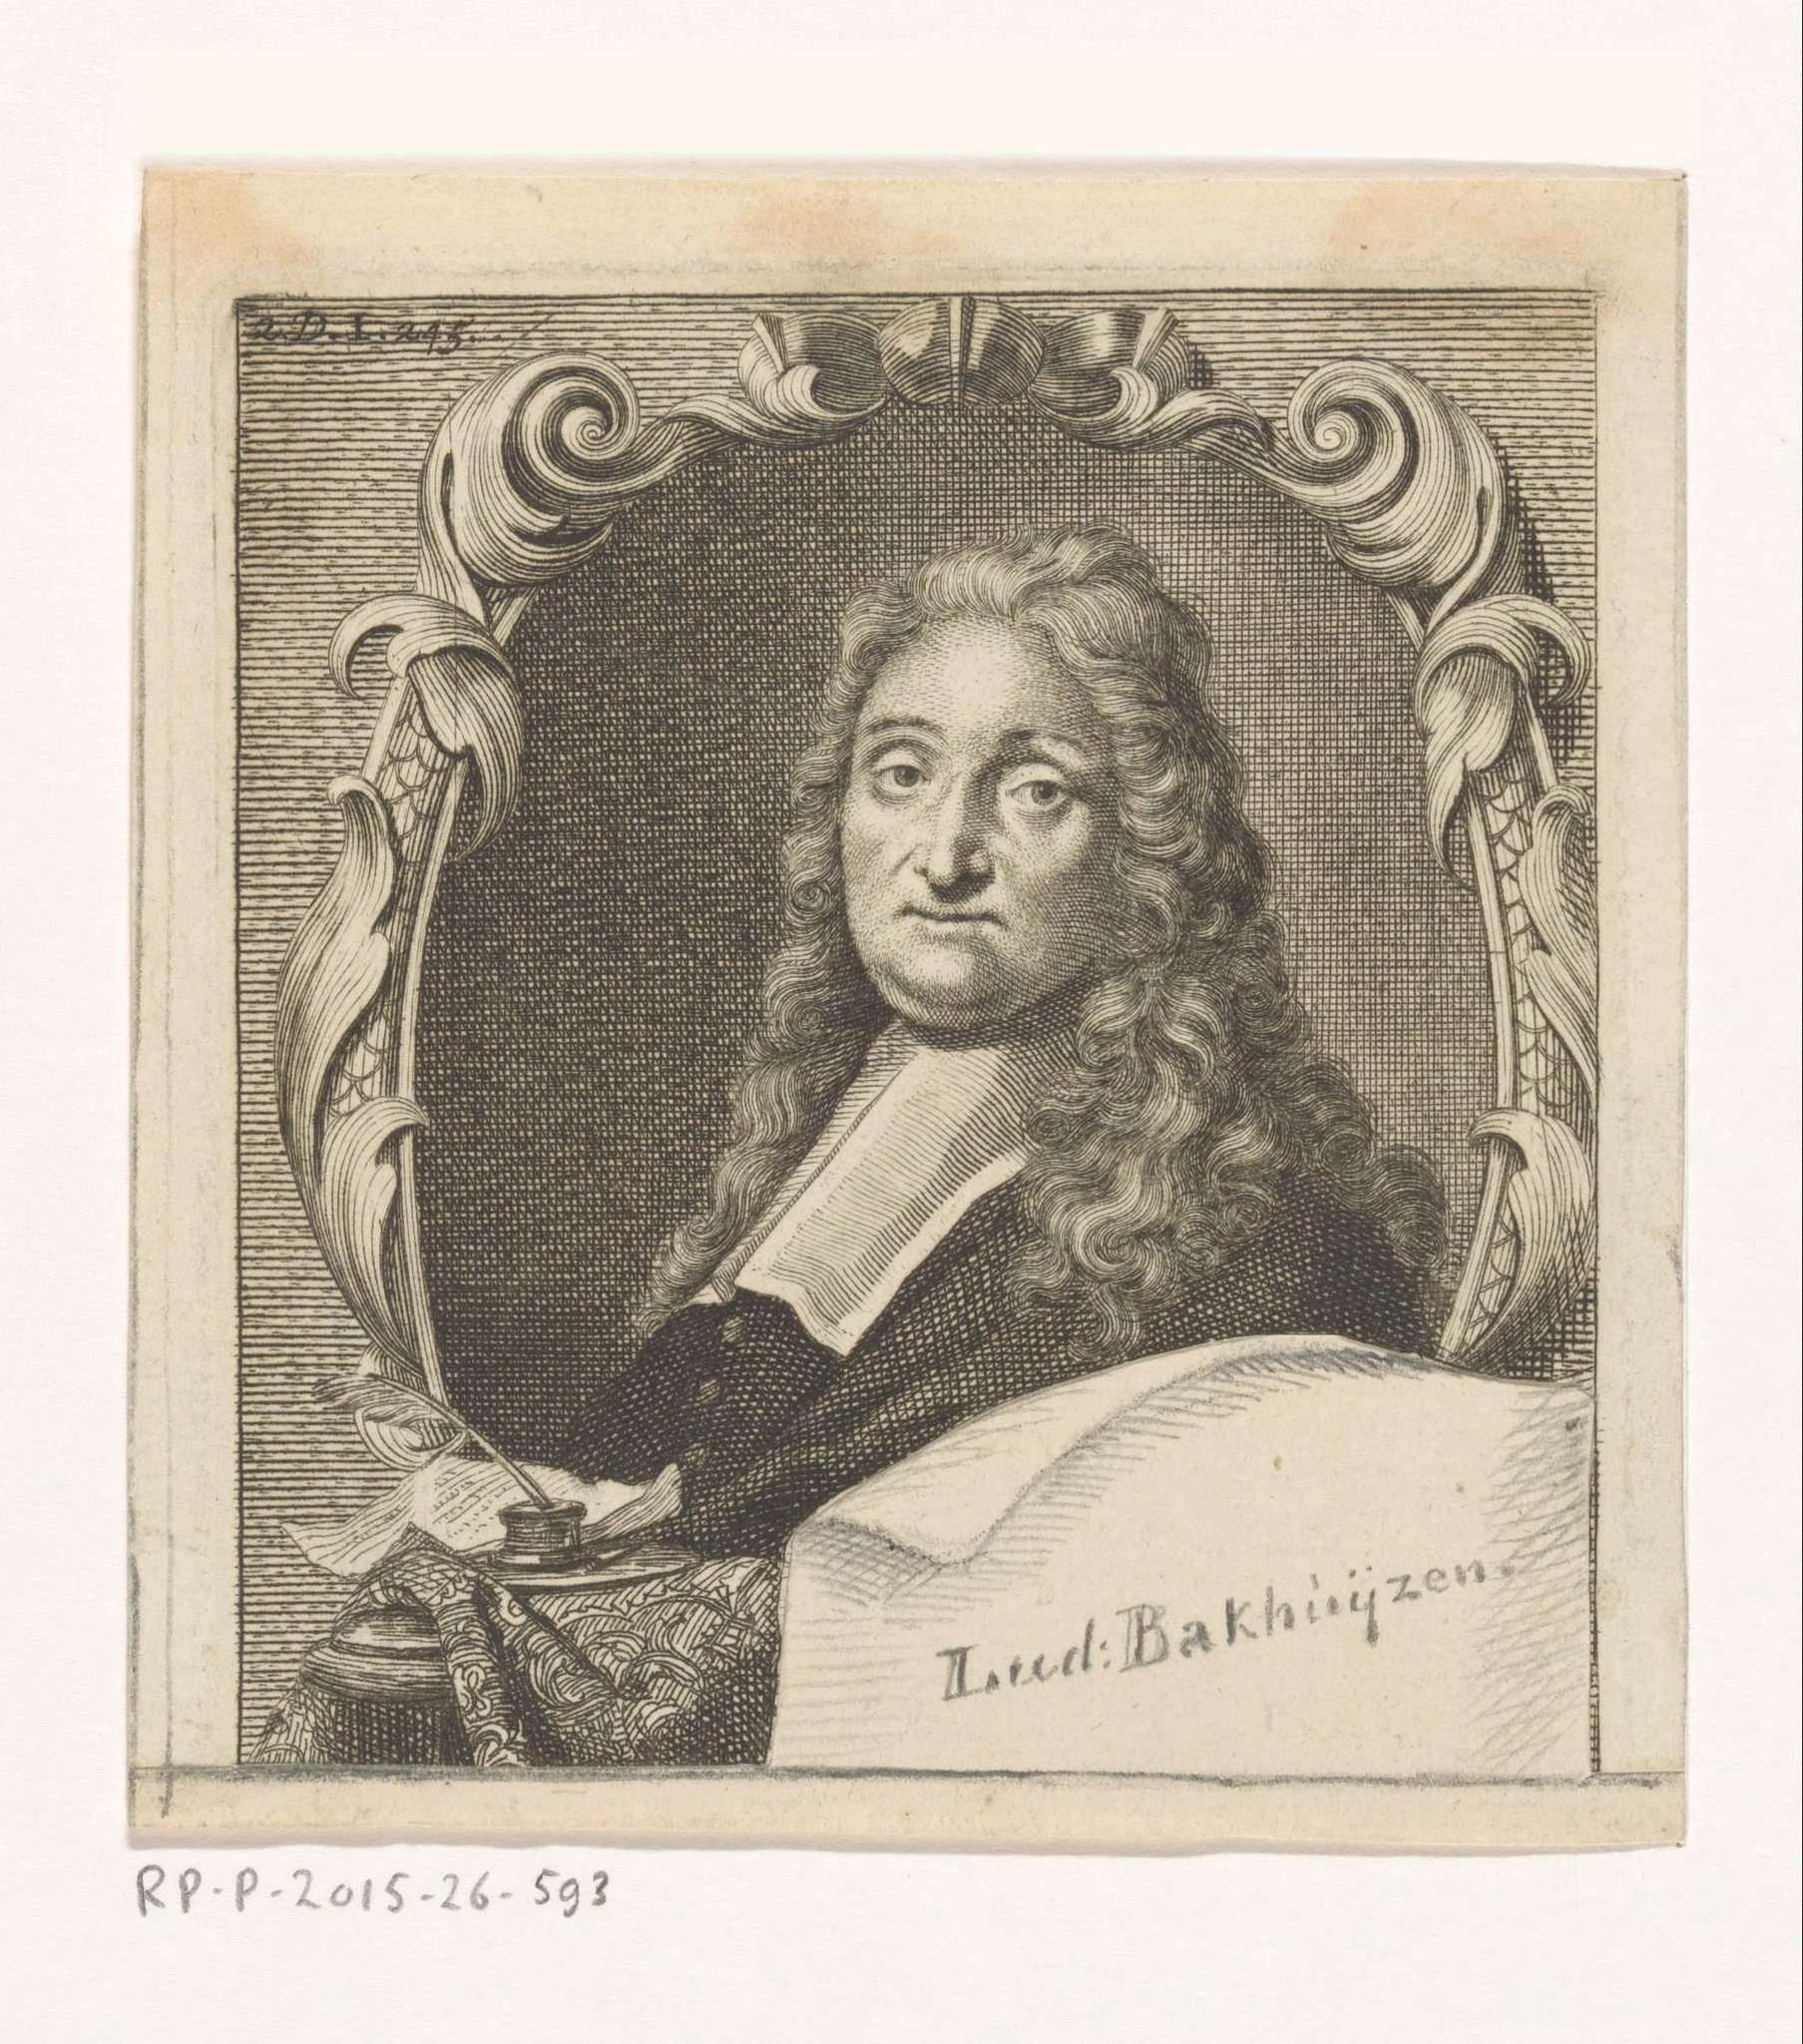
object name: book illustration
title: Portret van Ludolf Bakhuysen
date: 1753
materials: paper, pencil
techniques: engraving, etching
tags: draughtsman, ludolf bakhuysen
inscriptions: collector's mark: Lugt 4779, collector's mark: Lugt 2228, collector's mark: Lugt 4780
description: Prent afkomstig uit: Houbraken, Arnold. De groote schouburgh der Nederlantsche konstschilders en schilderessen. 3 Dln. Den Haag: Swart, Boucquet en Gaillard, 2e druk, 1753, dl. 1, voor p. 245. Een ander portret dat zich op dezelfde prent bevond is weggesneden en vervangen door een stuk papier waar met potlood "Lud. Bakhuijzen" op is geschreven.